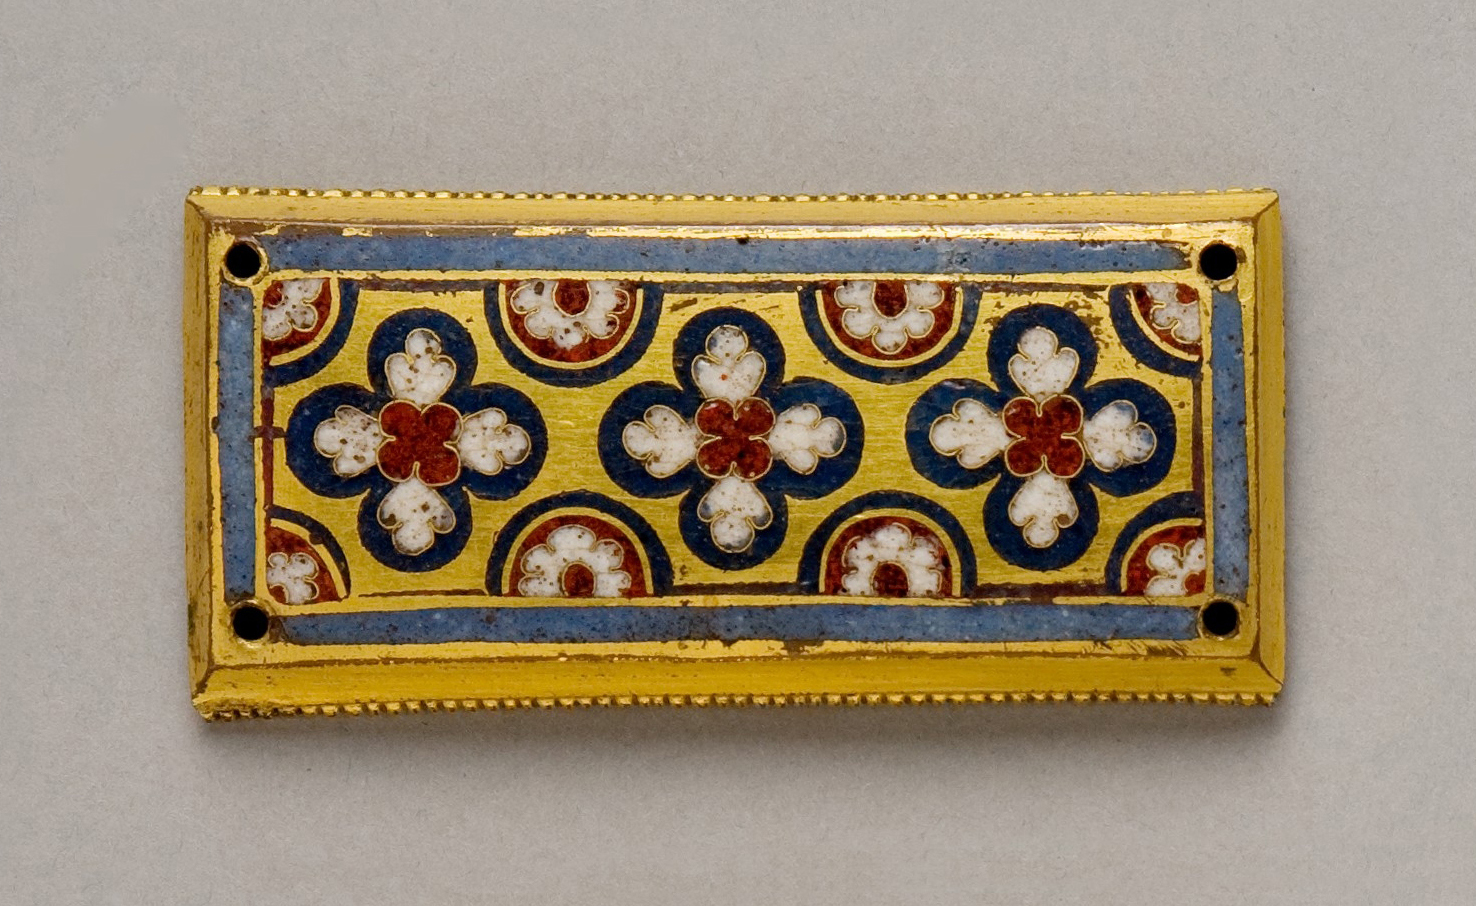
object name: plaque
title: Plaque from a Reliquary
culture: german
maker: master of the virgin mary's reliquary casket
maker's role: artist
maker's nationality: german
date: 1201-1233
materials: gilt copper, enamel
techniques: enamel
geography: germany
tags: flowers